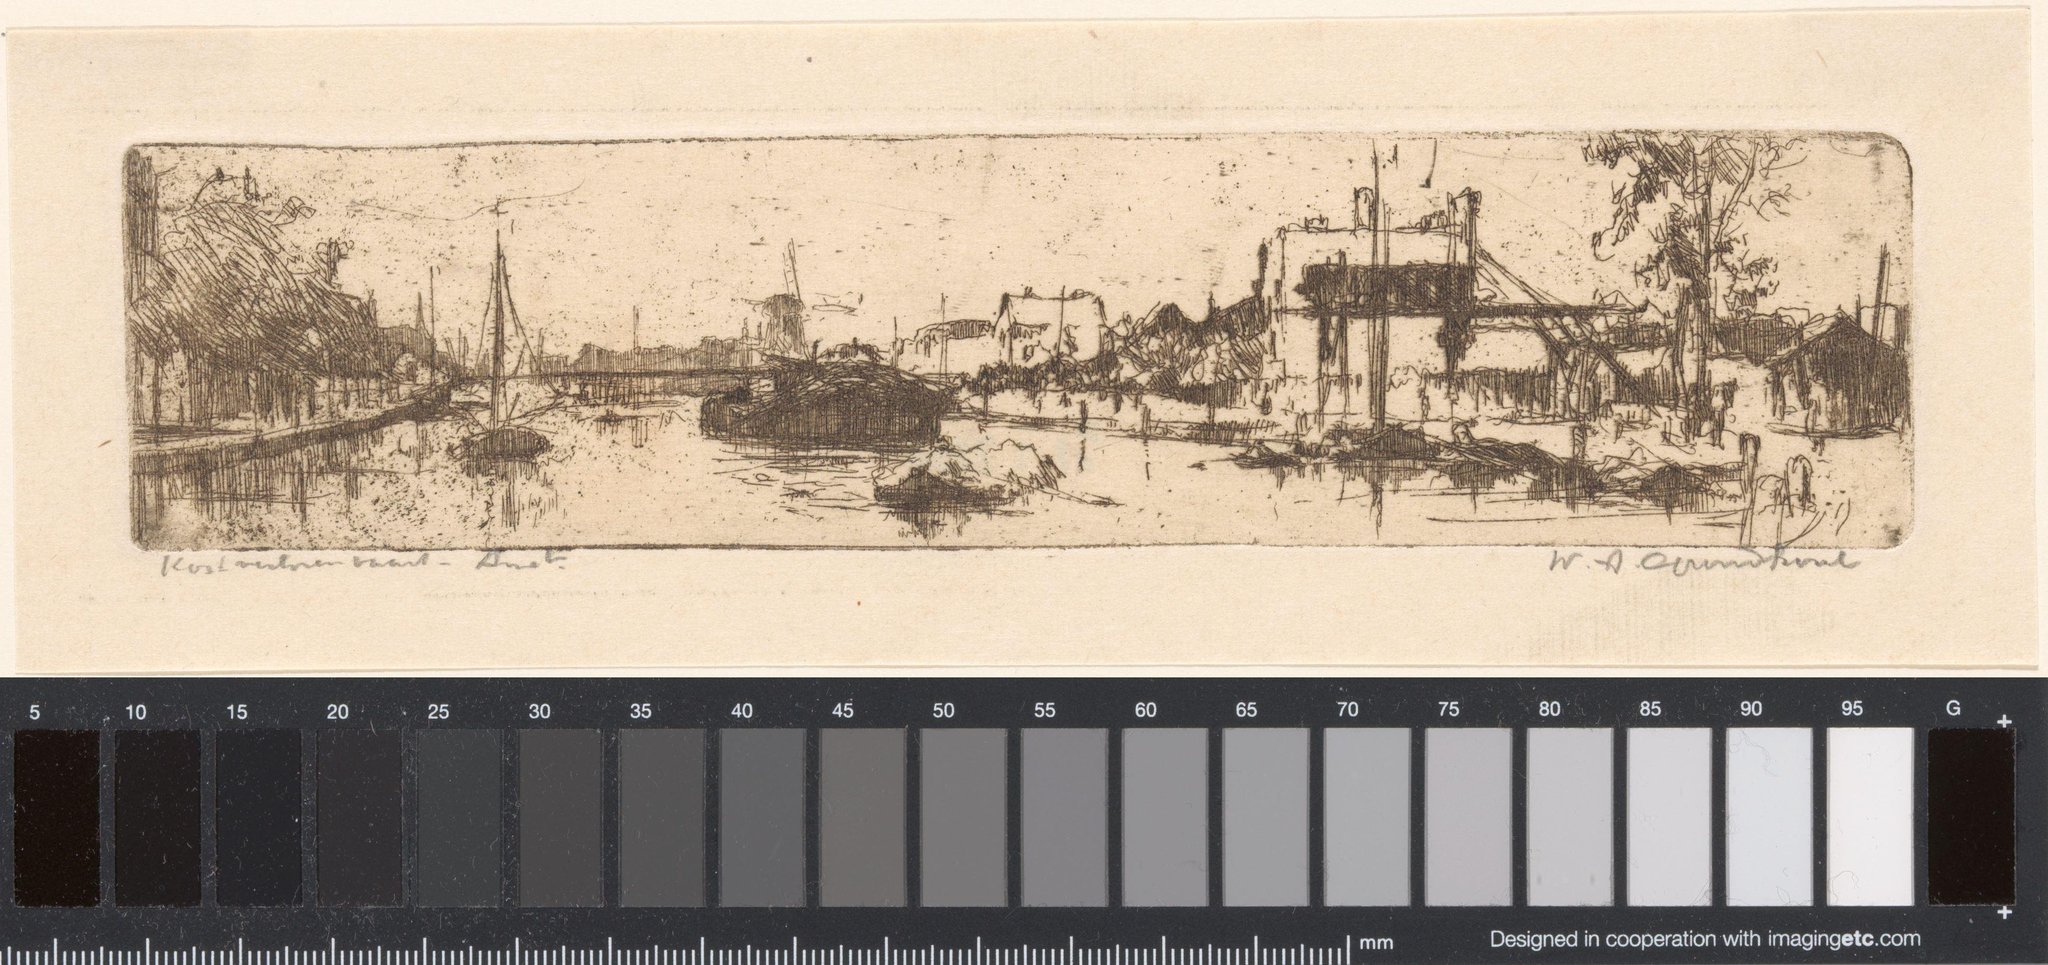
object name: print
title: Brug in Delft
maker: willem adrianus grondhout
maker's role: draughtsman, painter, print maker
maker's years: 1878-1934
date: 1888-1931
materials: paper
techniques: etching, intaglio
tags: bridge in city across river, canal, etc., delft